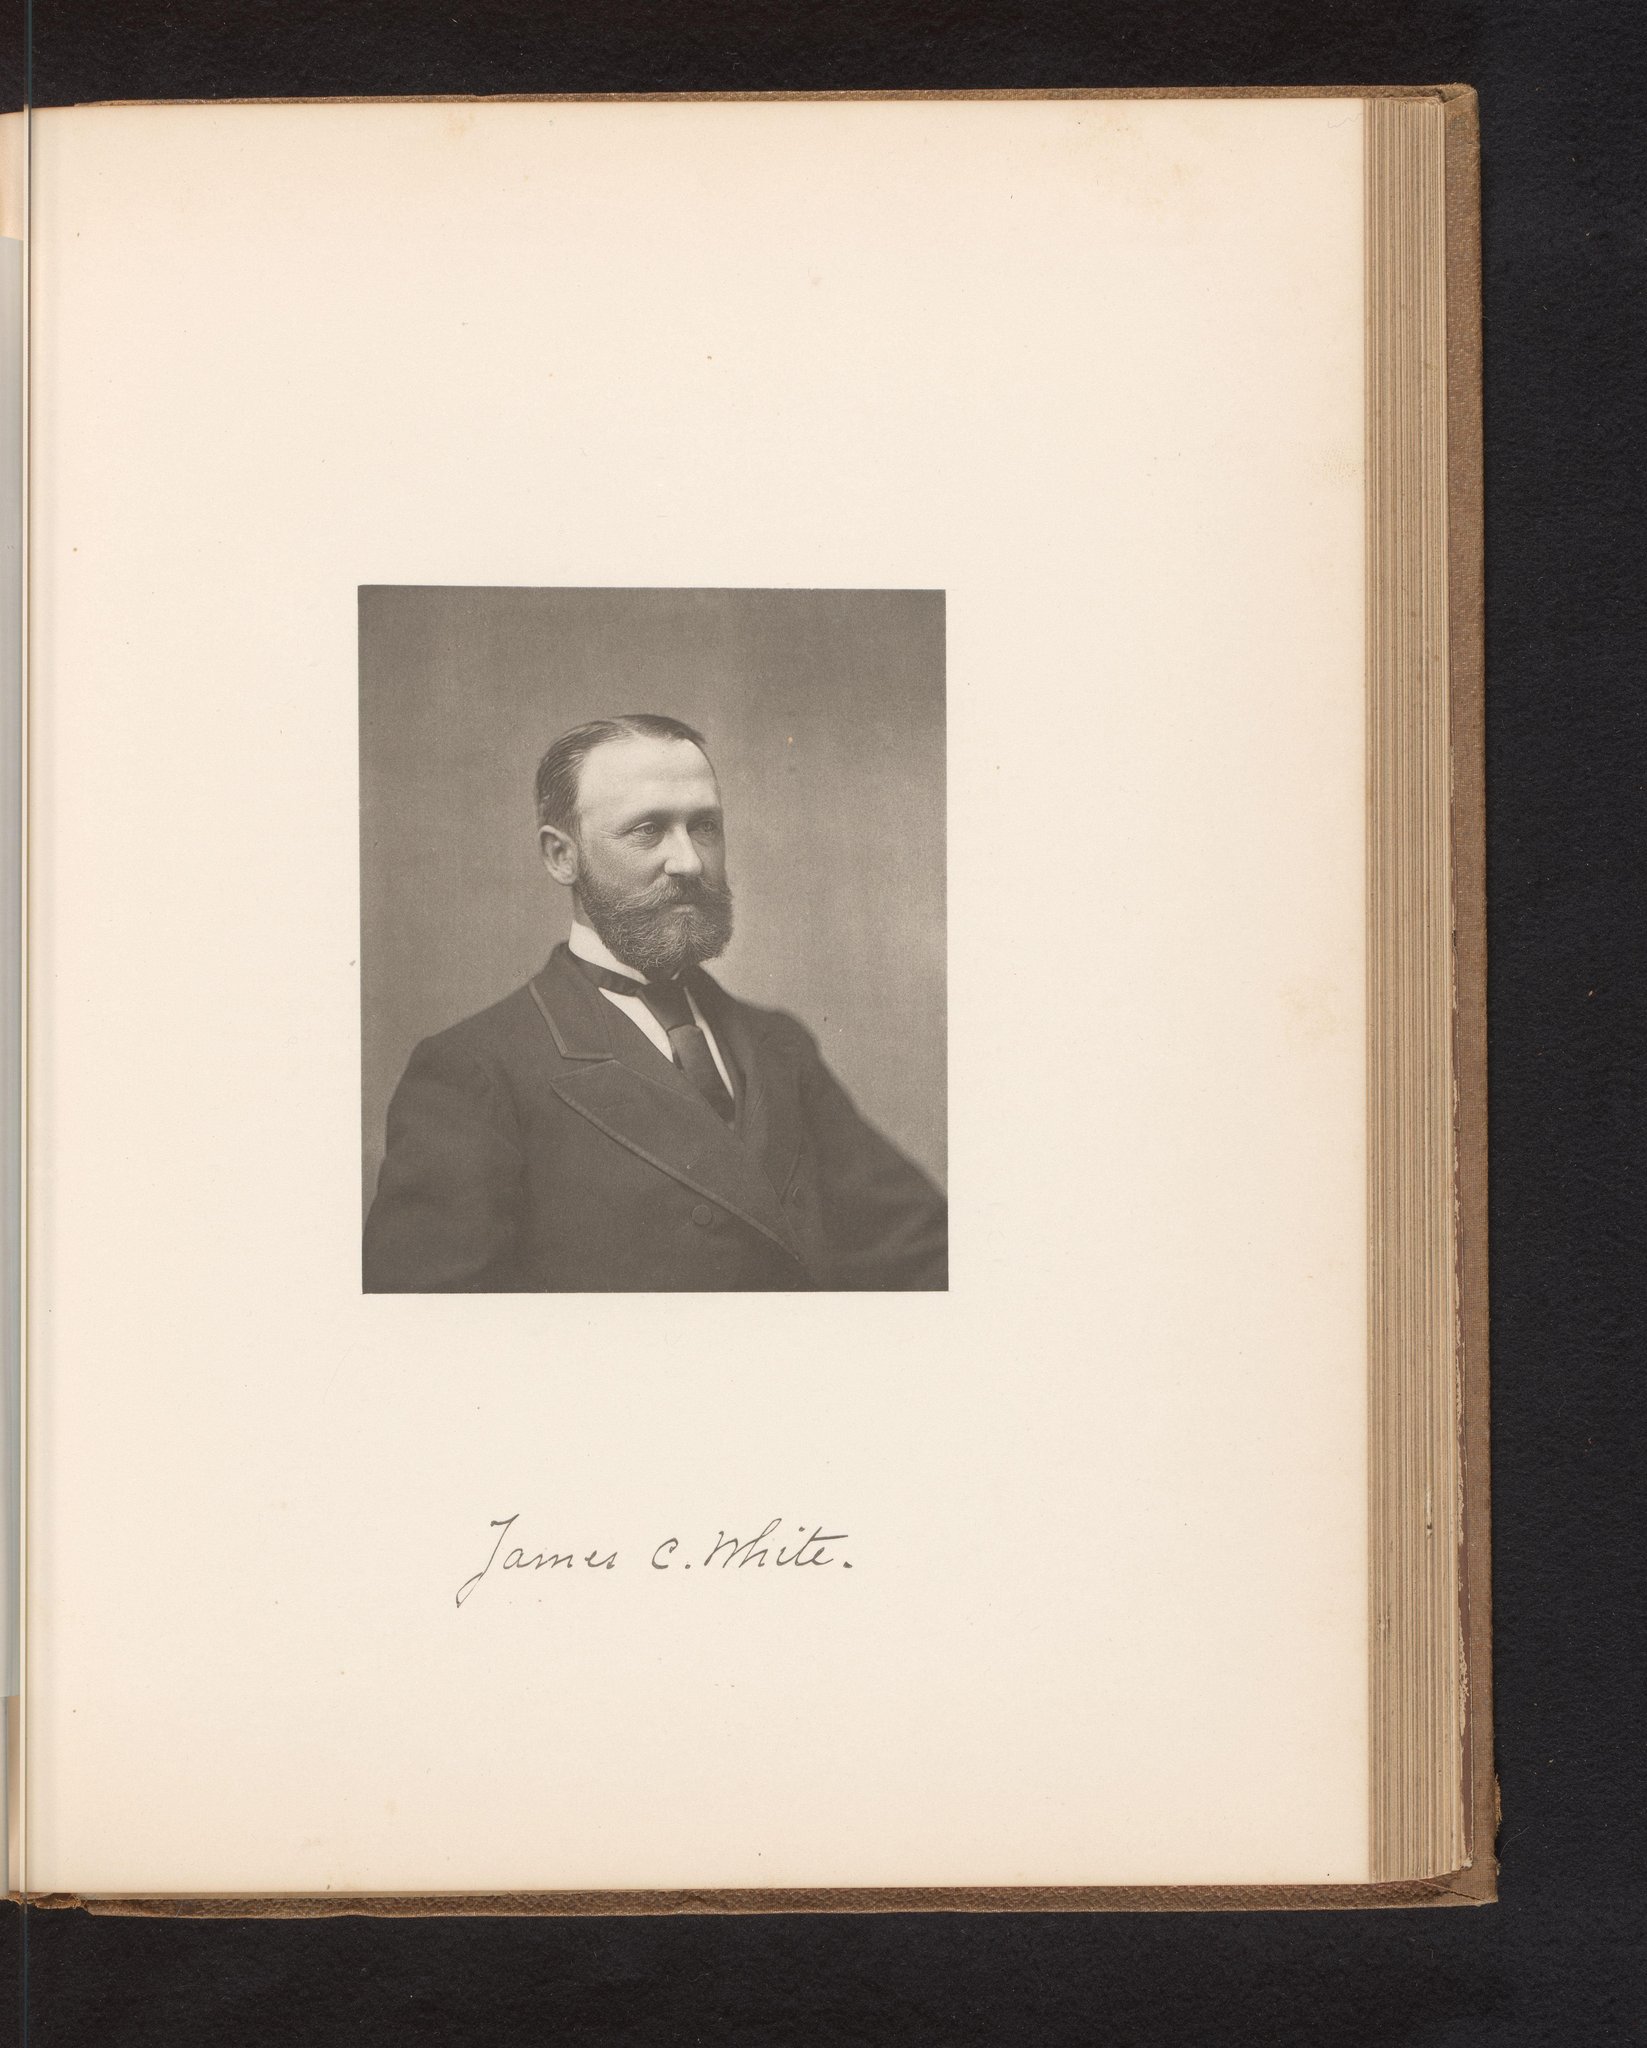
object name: page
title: James C. White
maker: Anonymous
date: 1870-1875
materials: paper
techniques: photograph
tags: historical persons, physician, doctor, professor